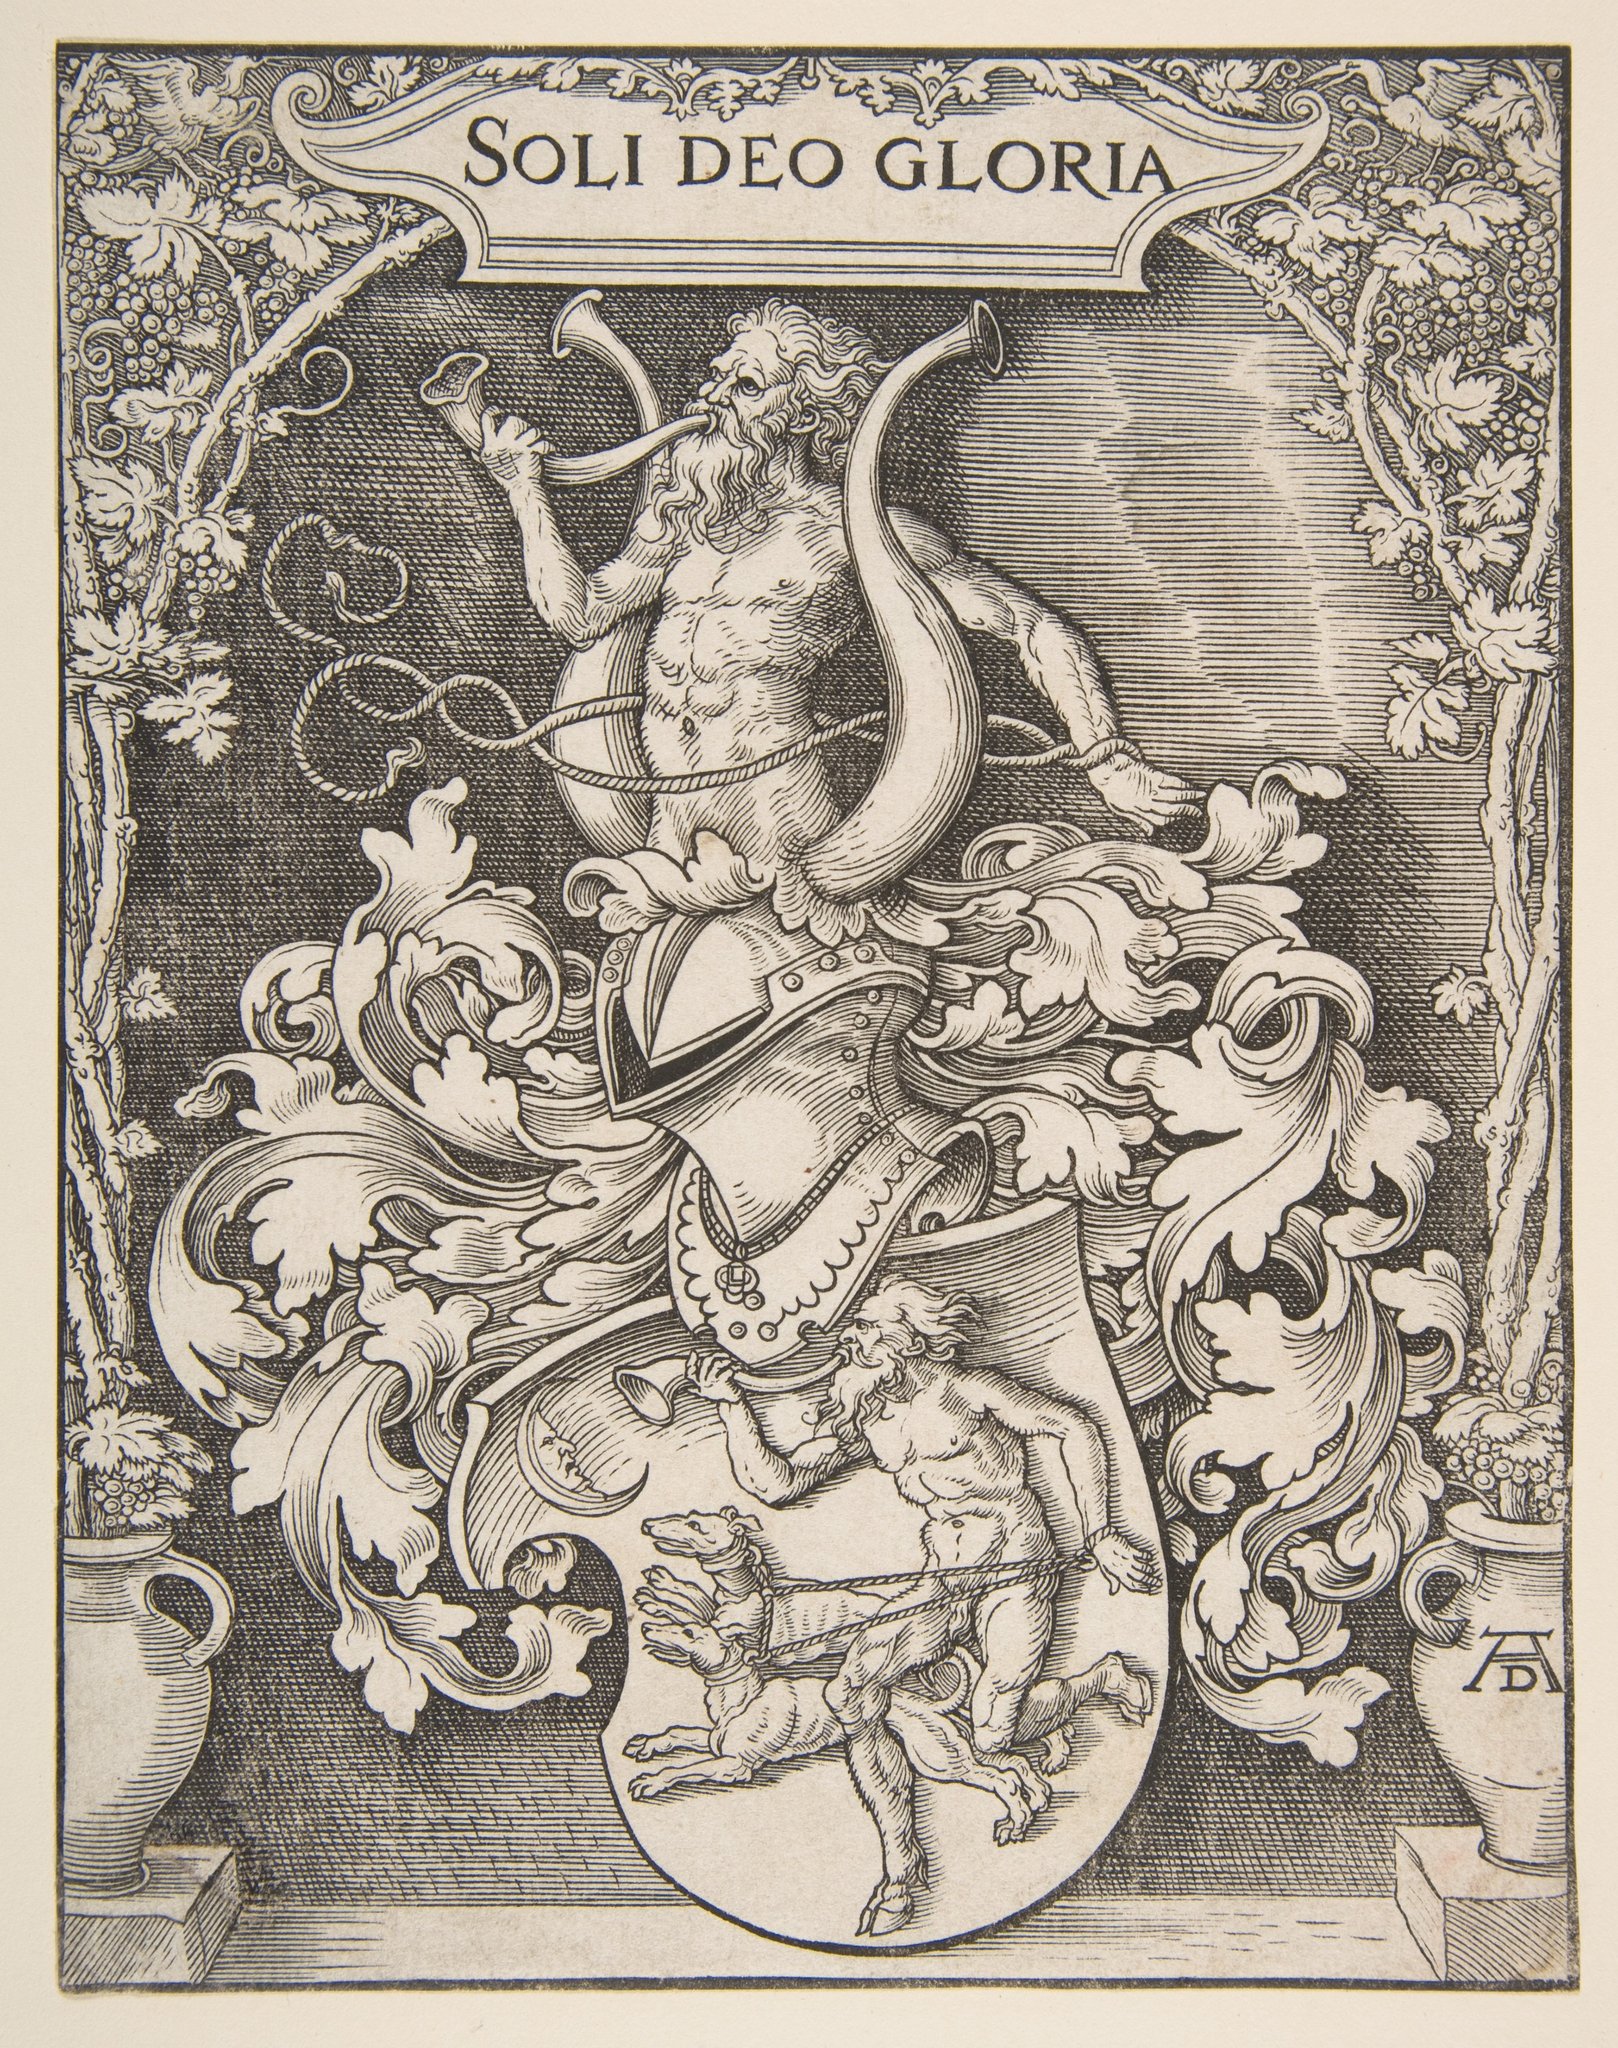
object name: print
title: Coat of Arms of Johann Tscherte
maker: albrecht dürer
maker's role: artist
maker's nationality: german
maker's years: 1471-1528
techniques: woodcut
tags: musical instruments,helmets,men,male nudes,horns,fauns,dogs,flowers,leaves,coat of arms